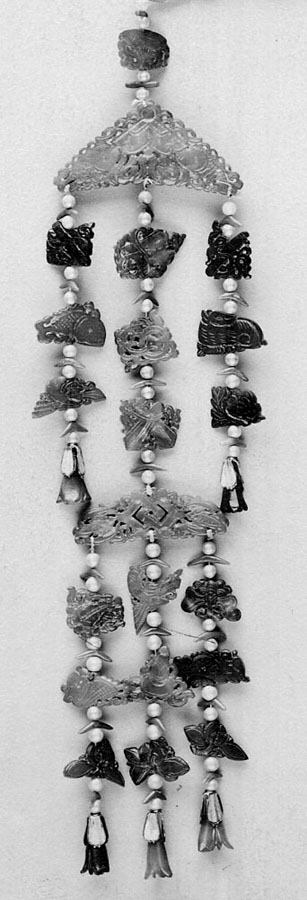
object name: headdress ornament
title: Ornament for a Headdress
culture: chinese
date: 1701-1800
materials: amber, coral, pearl